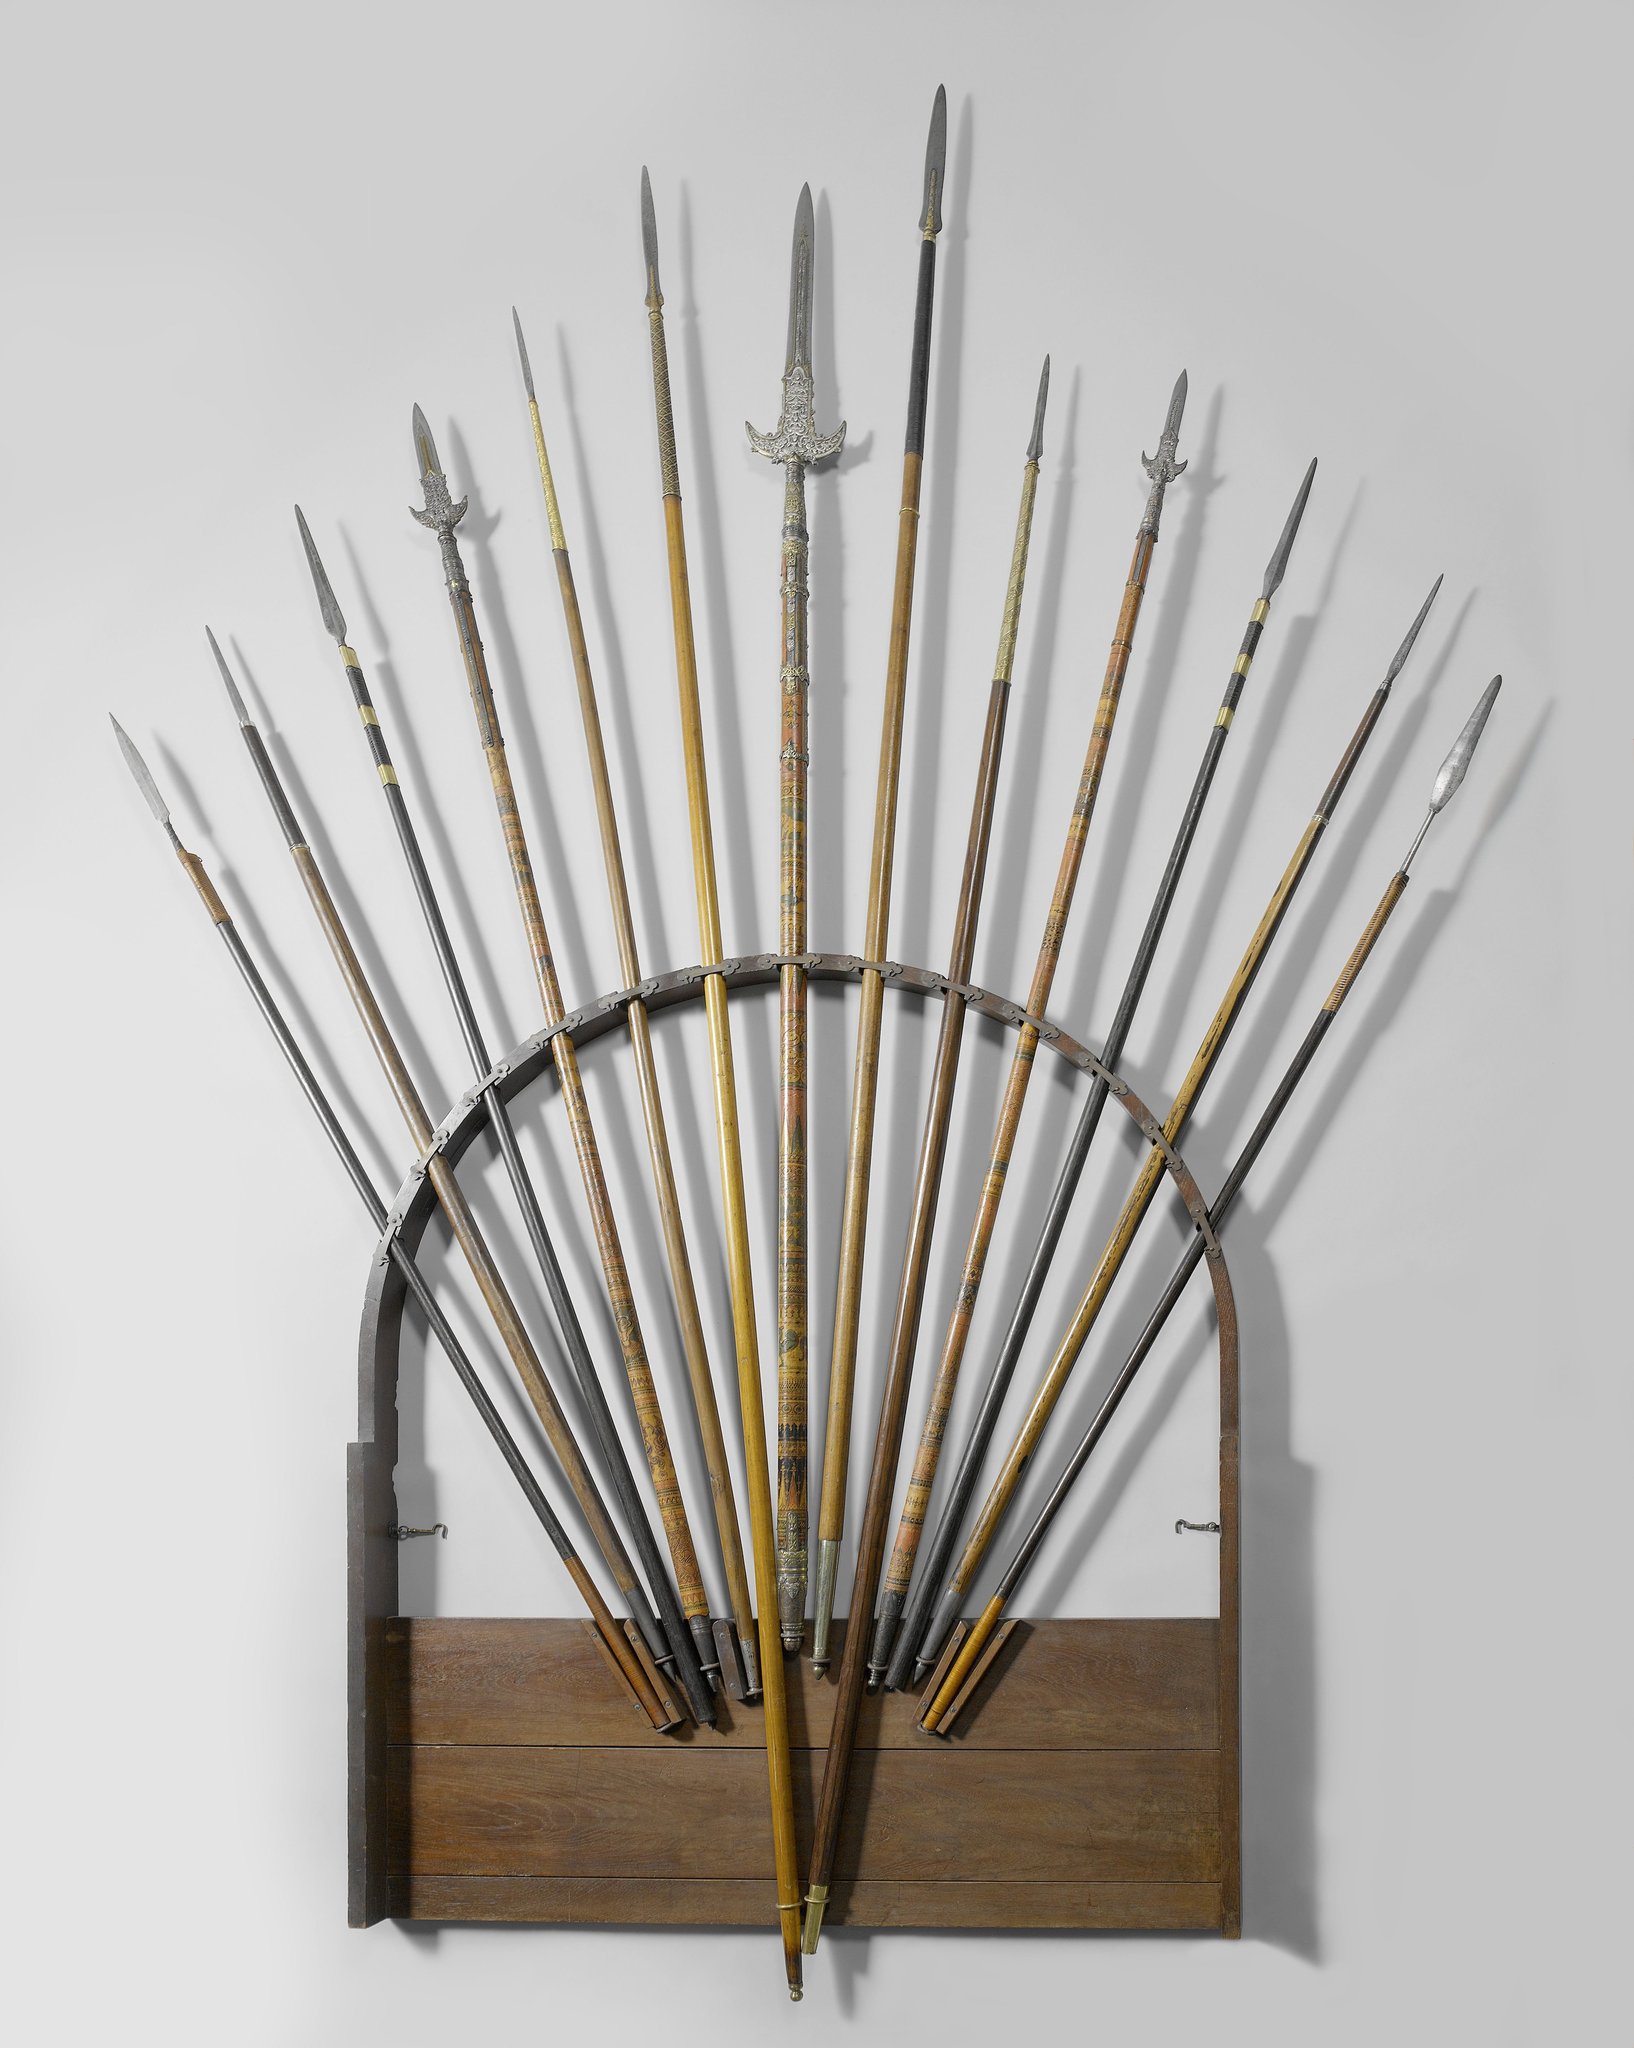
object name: rack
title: Spear Rack of Governor-General J.C. Baud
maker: Anonymous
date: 1834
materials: brass, wood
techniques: casting, cutting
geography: indonesia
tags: the hague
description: Most of these spears were presented to J.C. Baud, Governor-General of the Dutch East Indies in 1834. The Java War (1825-1830), a bloody colonial war between the Dutch and the Java princes, cost the lives of 200,000 Javanese and 15,000 Dutchmen. Because unrest remained in parts of Java, Baud went on an inspection tour in 1834. During this journey he received weapons, traditional symbols of power, from local rulers as a token of their (extorted) loyalty to the Dutch government.